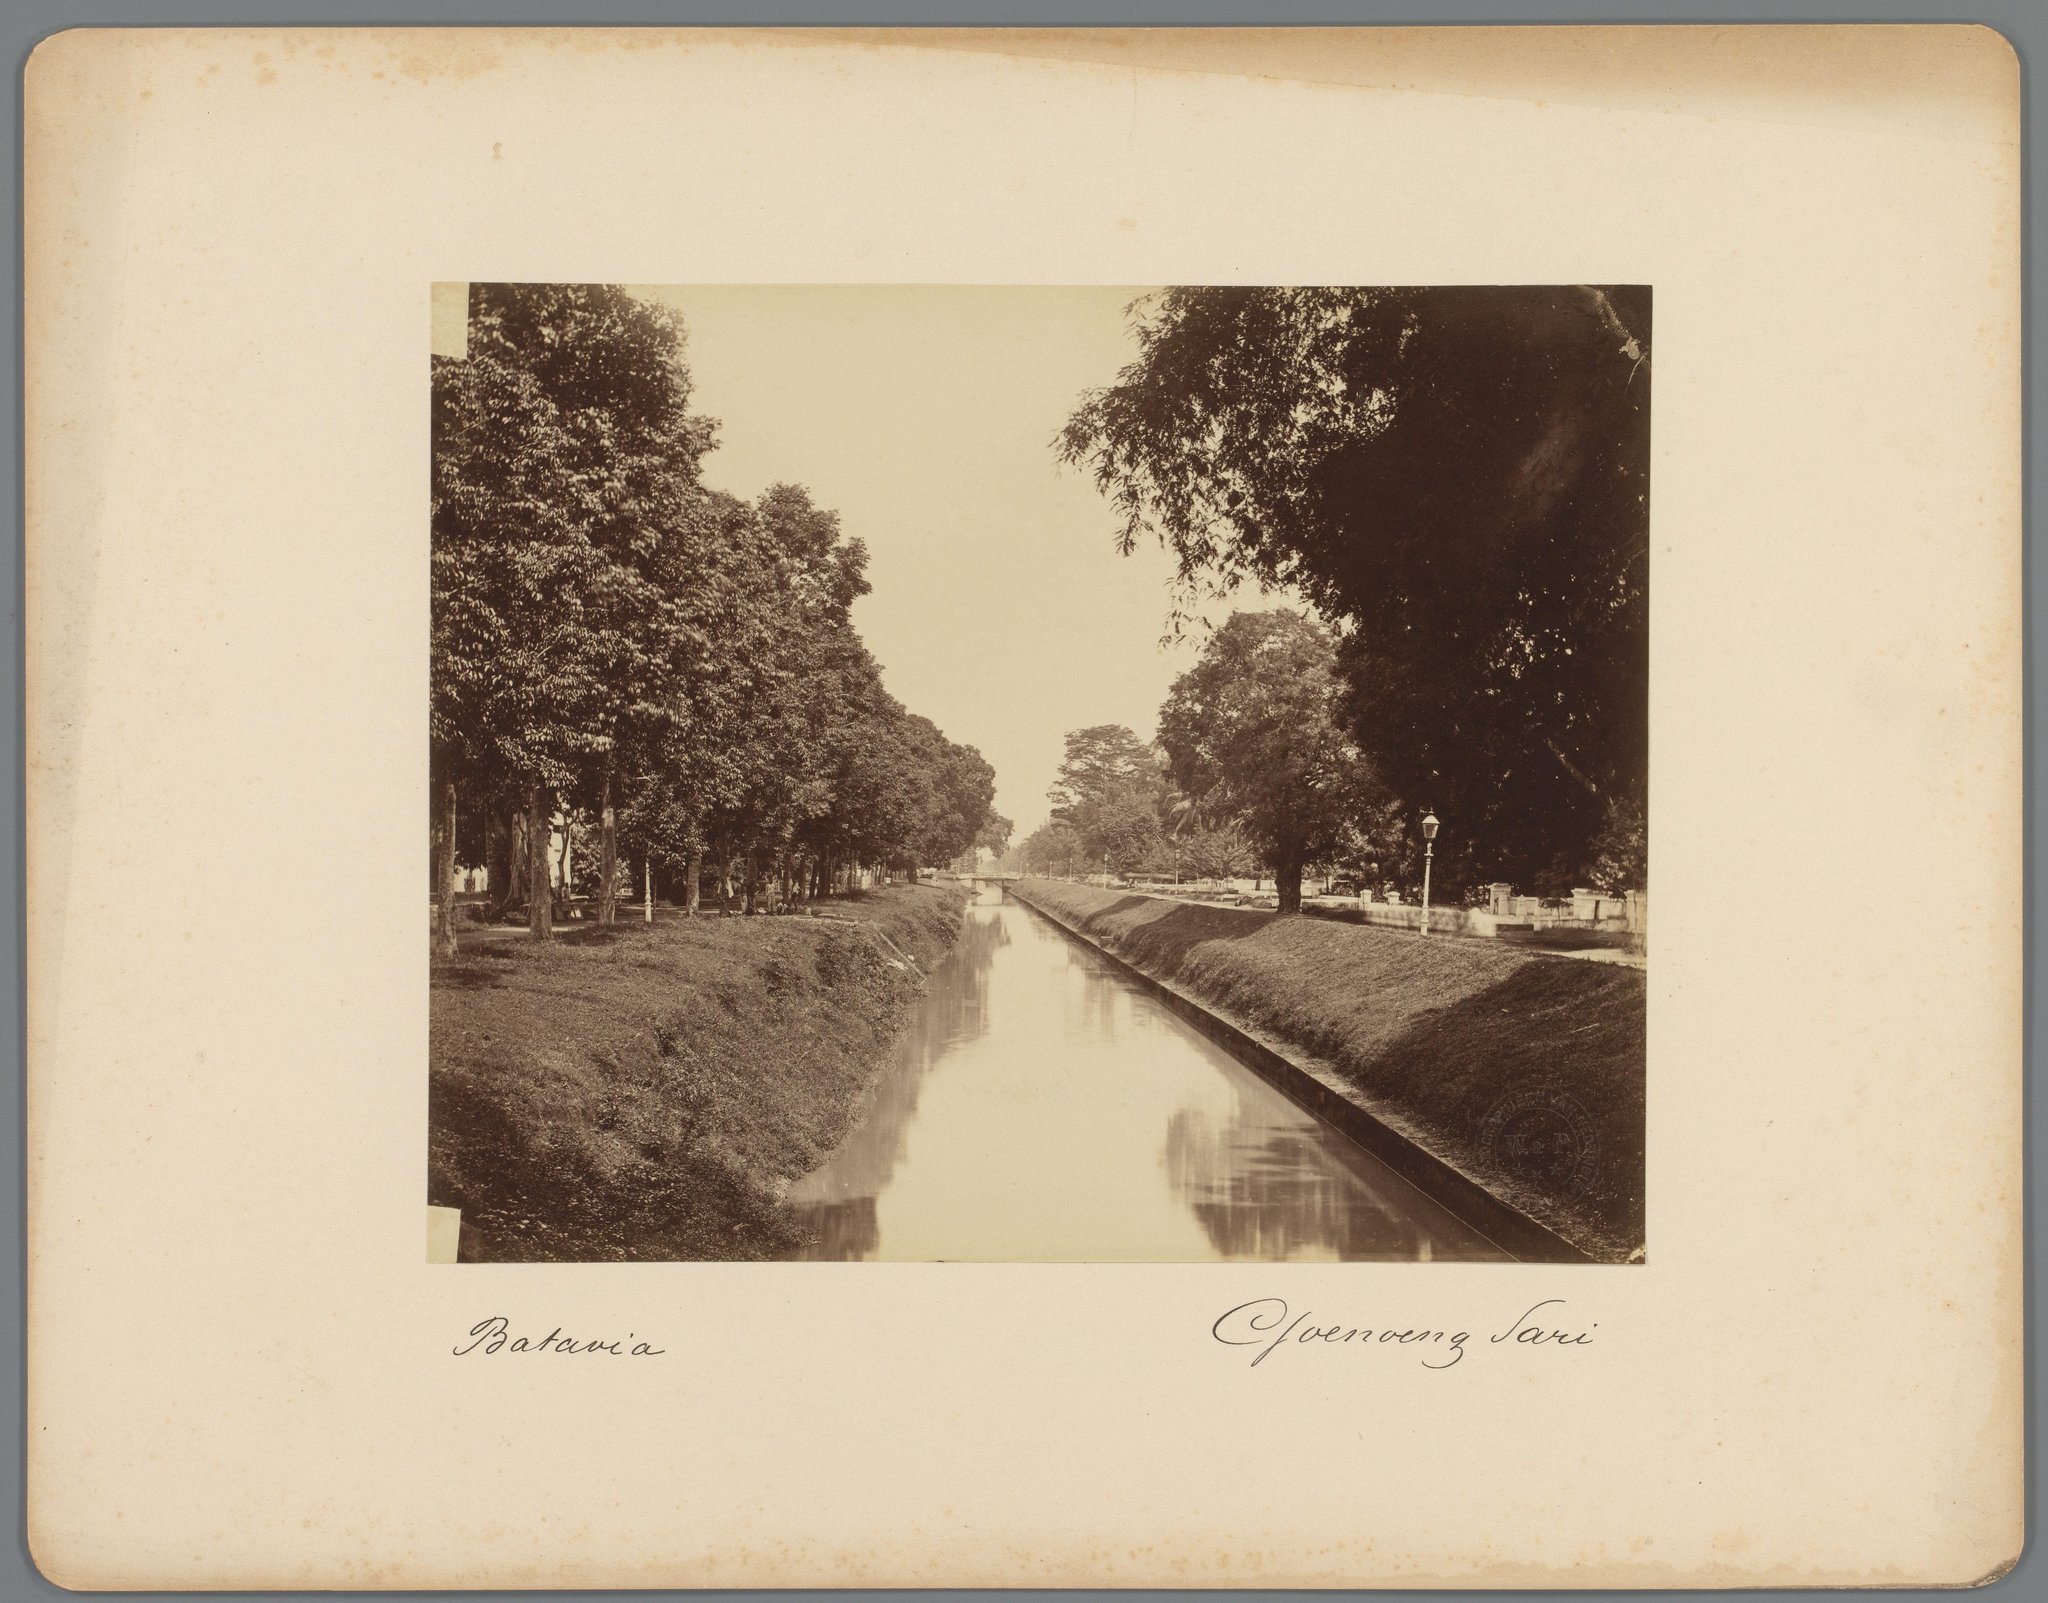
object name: photograph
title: Batavia, Goenoeng Sari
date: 1857-1908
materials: cardboard, paper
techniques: albumen print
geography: east java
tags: canal, batavia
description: Deze foto zat oorspronkelijk in prentenkabinet RP-F-AA3192.